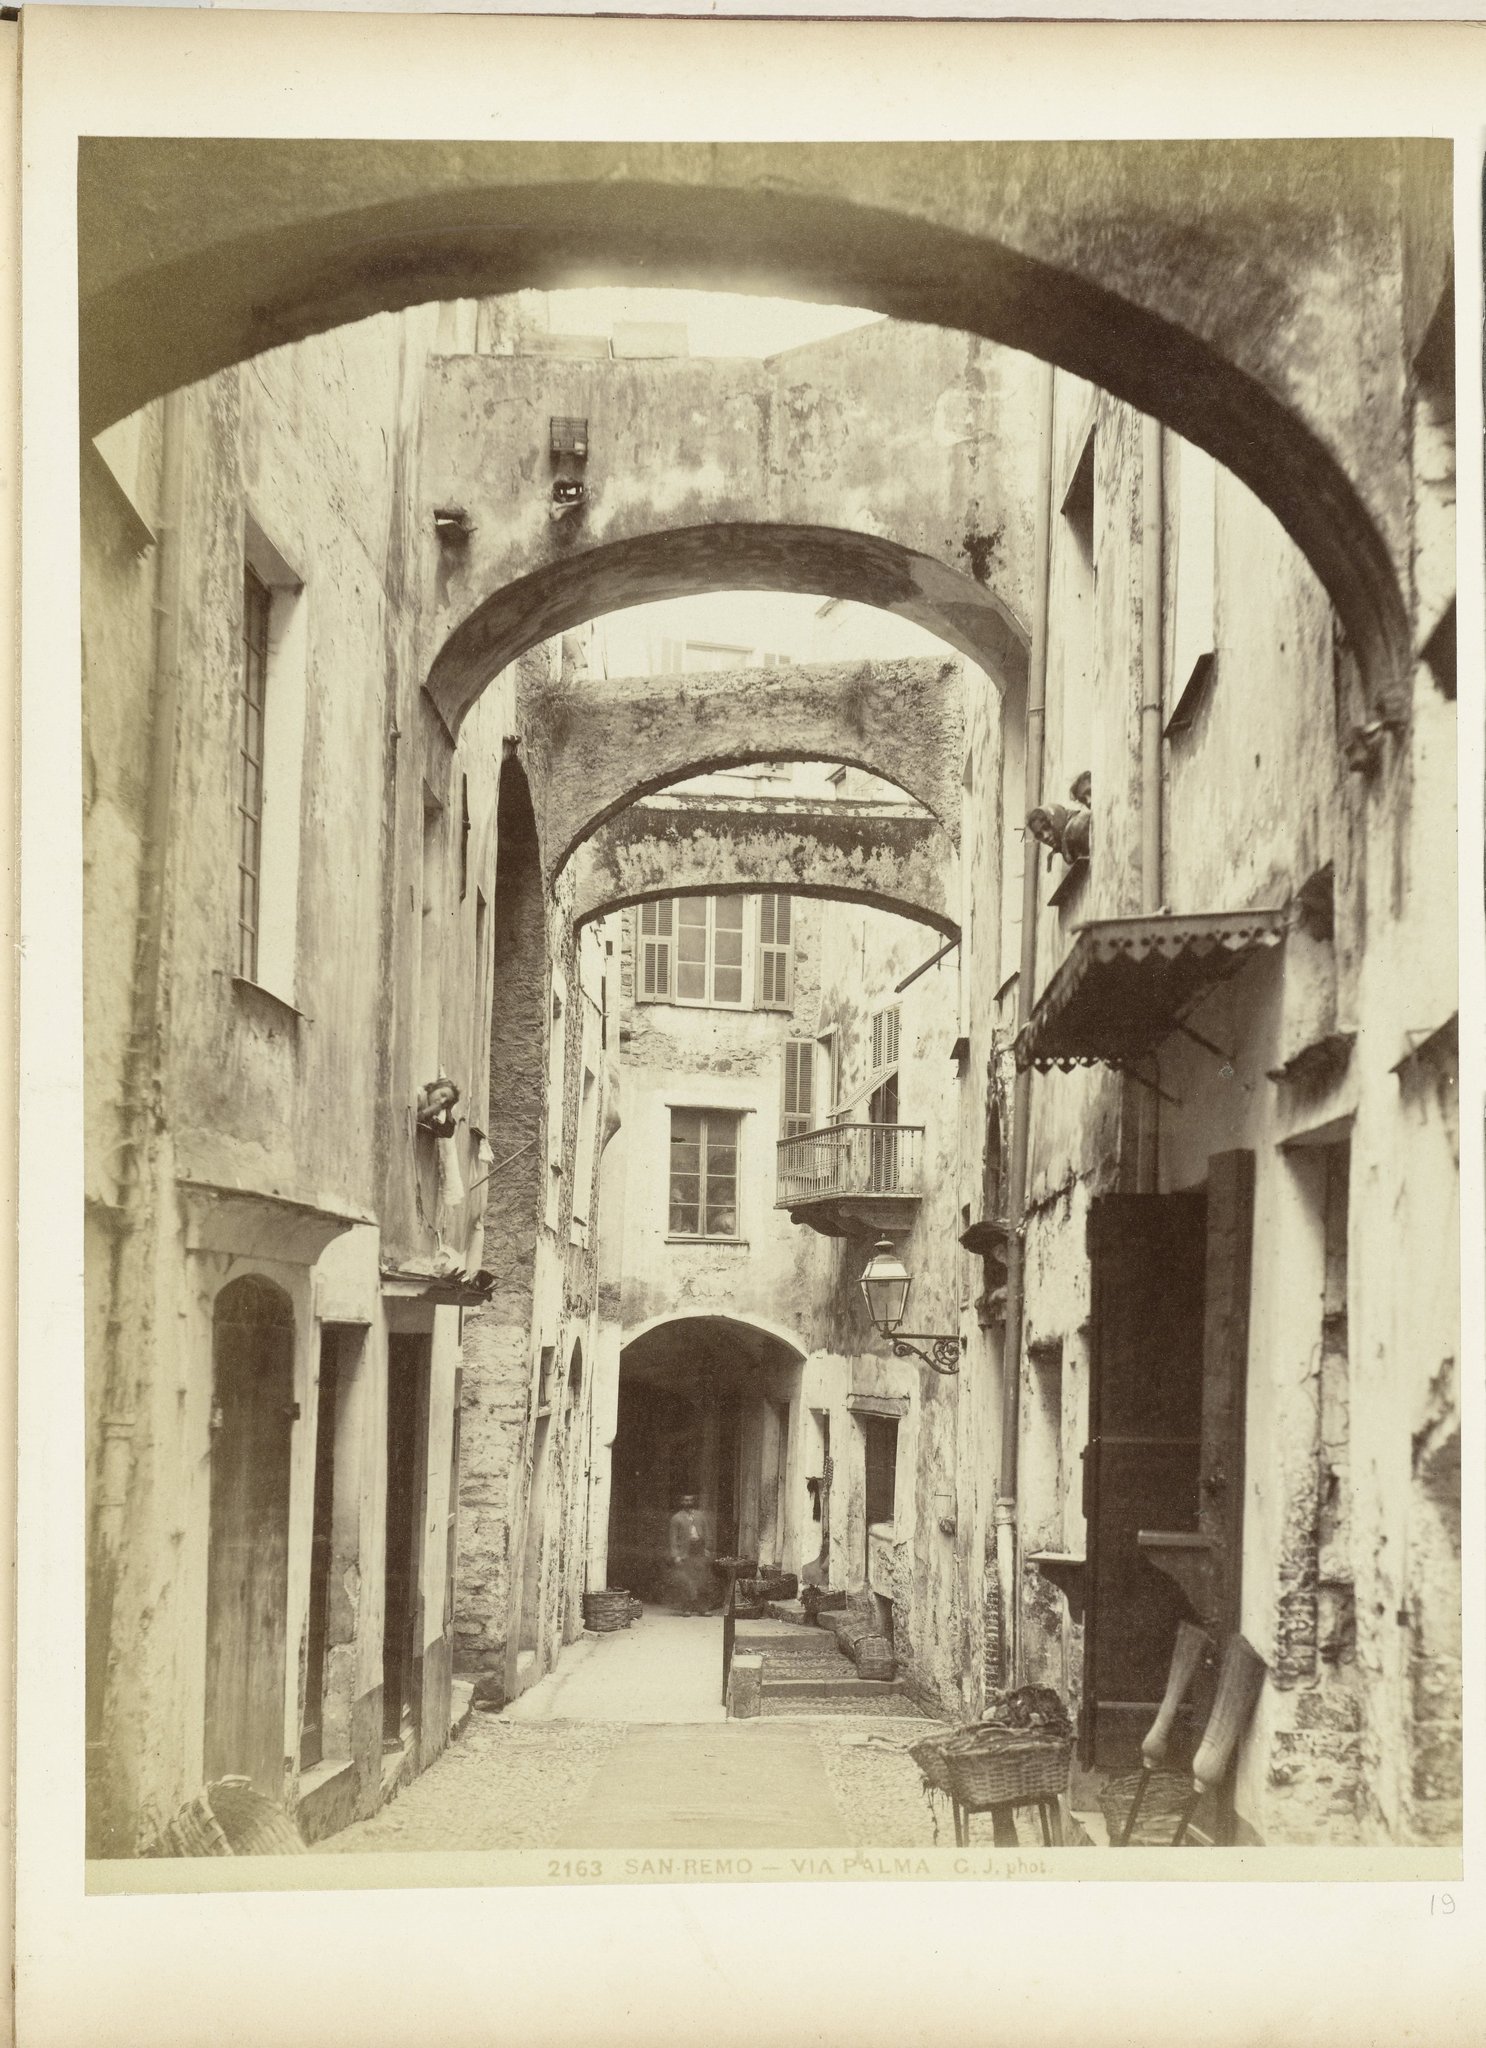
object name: photograph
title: 2163 San Remo, Via Palma G.J. Phot.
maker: jean gilletta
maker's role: fotograaf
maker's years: 1856-1933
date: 1886-1896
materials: cardboard, photographic support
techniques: albumen print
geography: italy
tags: san remo